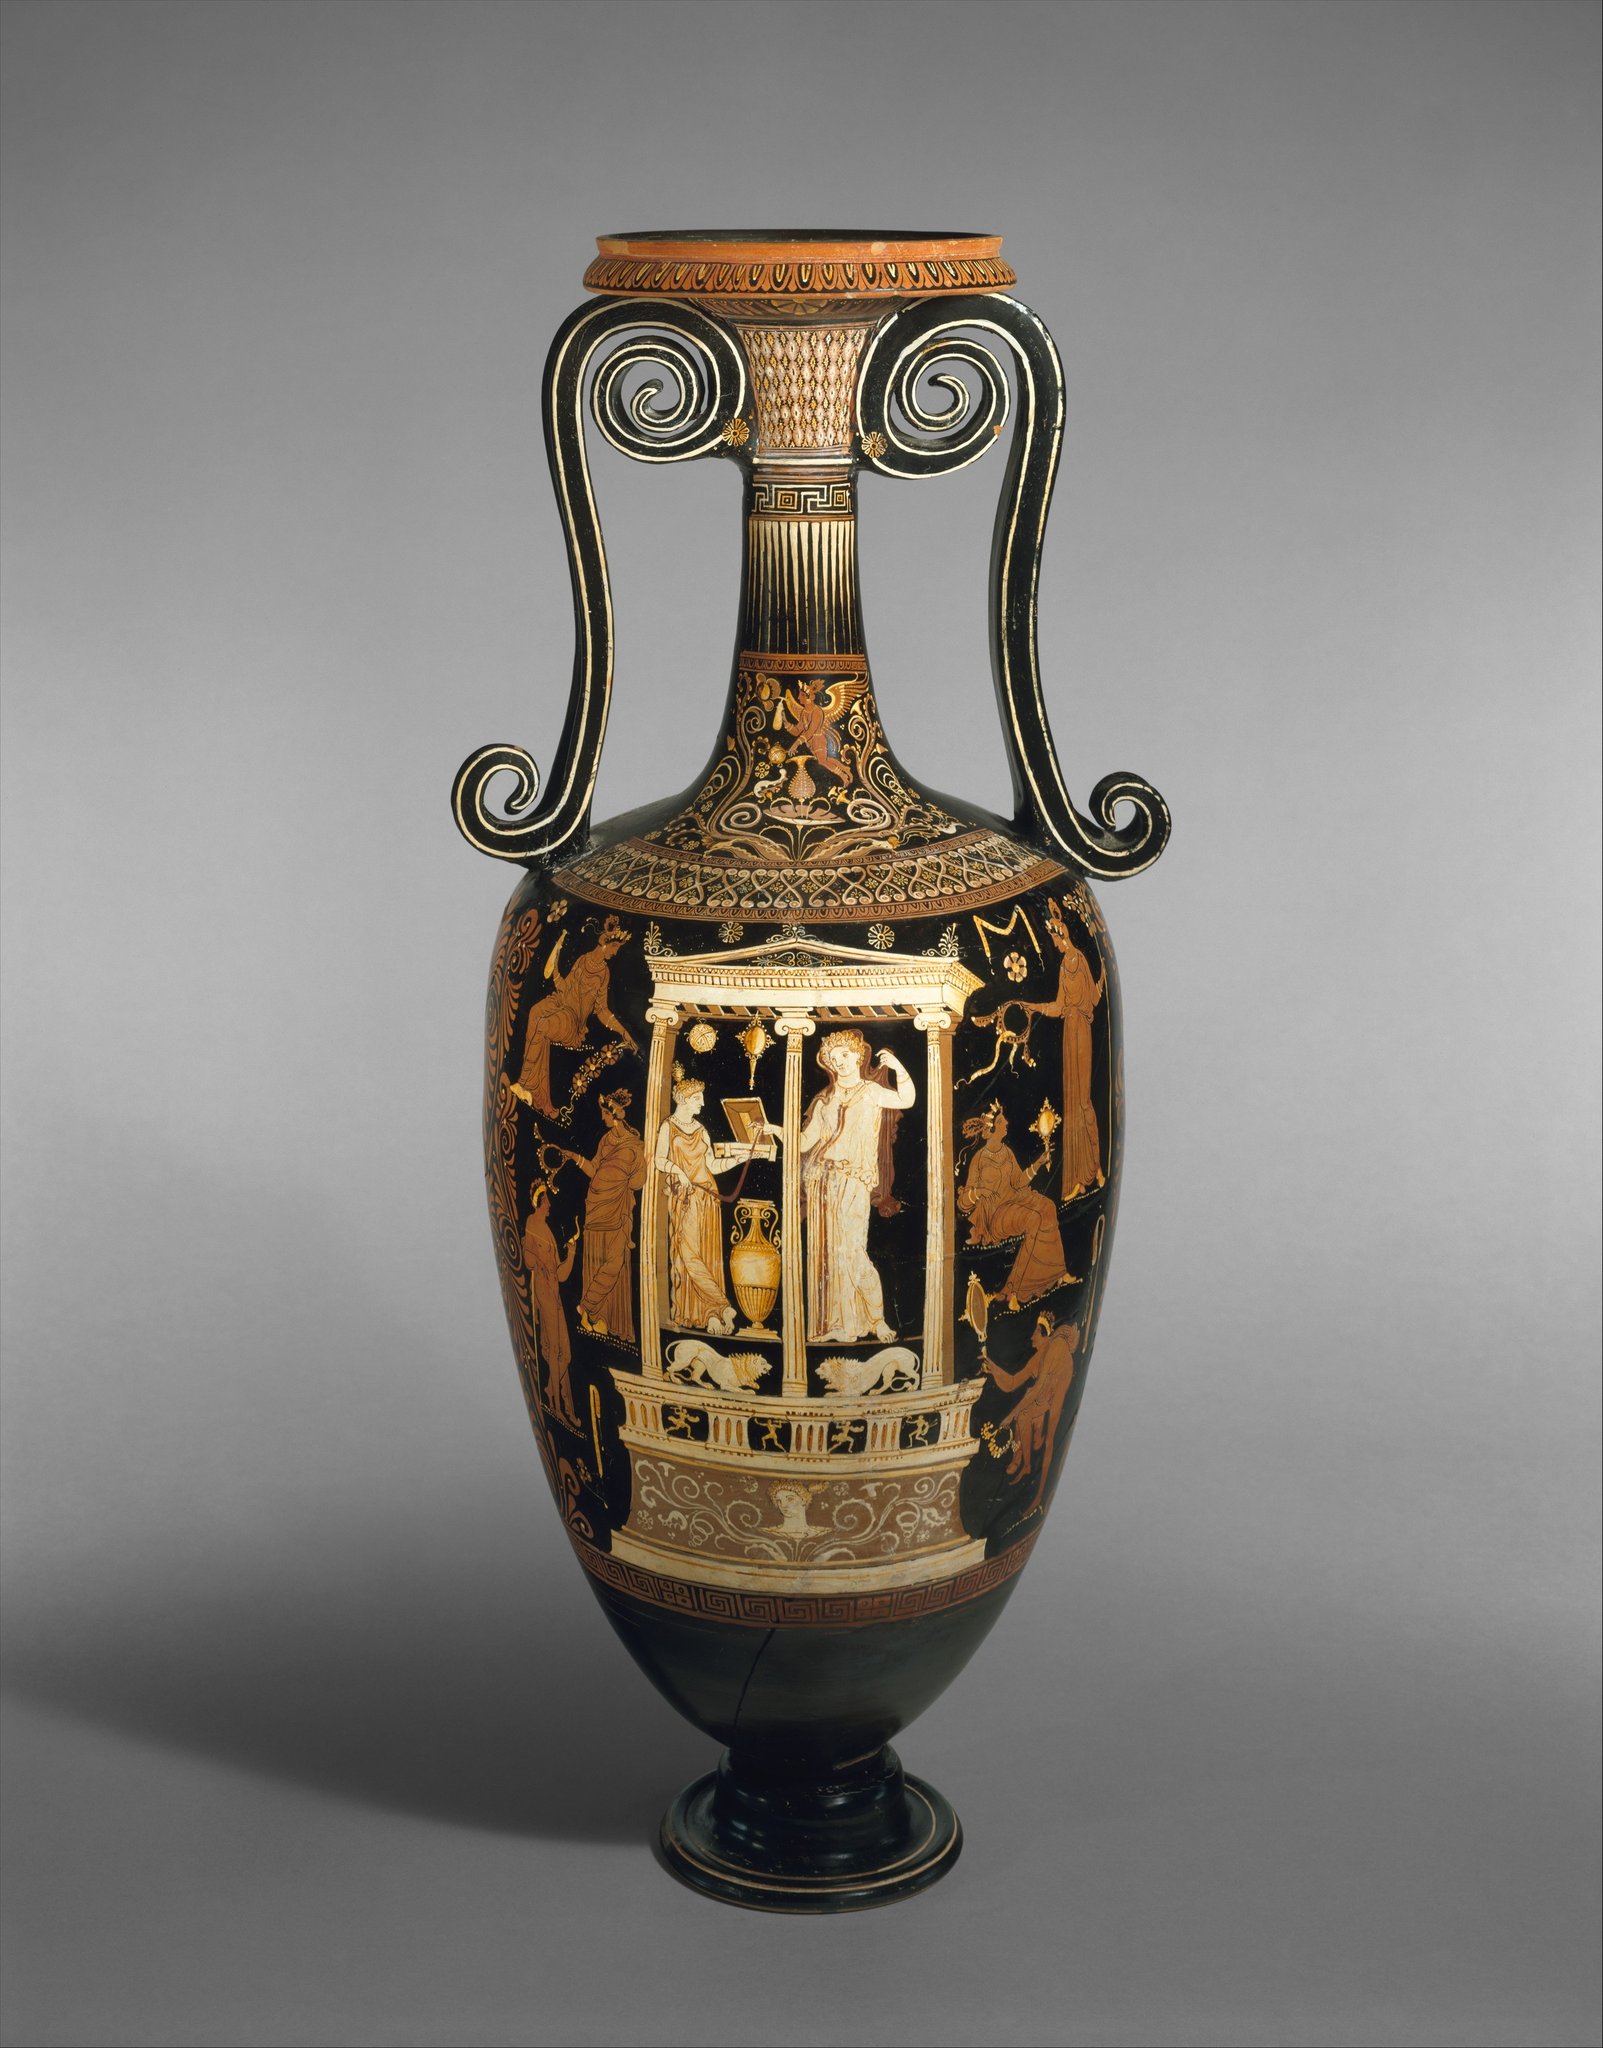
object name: loutrophoros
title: Terracotta loutrophoros (ceremonial vase for water)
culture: greek, south italian, apulian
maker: metope painter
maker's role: artist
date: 350-326 BCE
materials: terracotta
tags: men,women,eros,mirrors